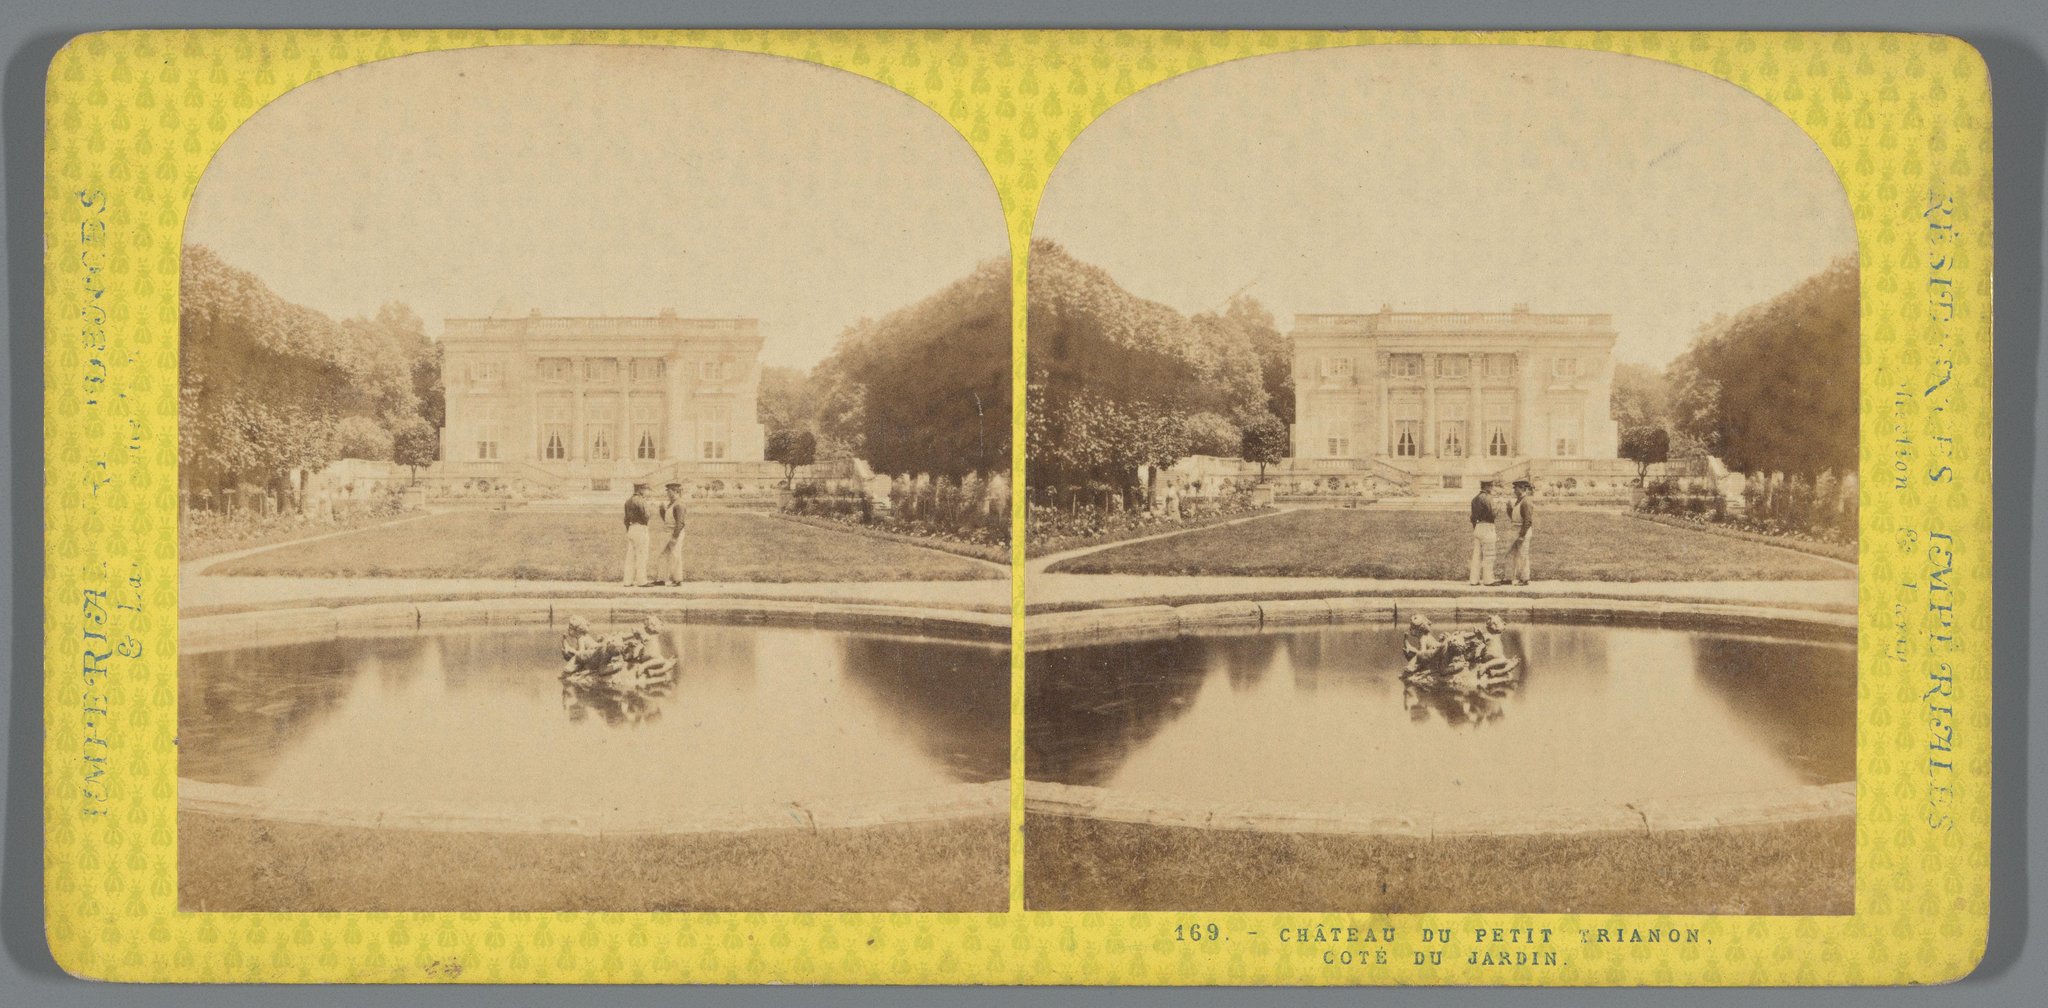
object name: stereograph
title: Gezicht op Klein Trianon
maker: ernest eléonor pierre lamy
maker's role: publisher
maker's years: 1828-1900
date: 1868-1878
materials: cardboard, paper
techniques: albumen print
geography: versailles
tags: palace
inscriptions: number: ‘169.’